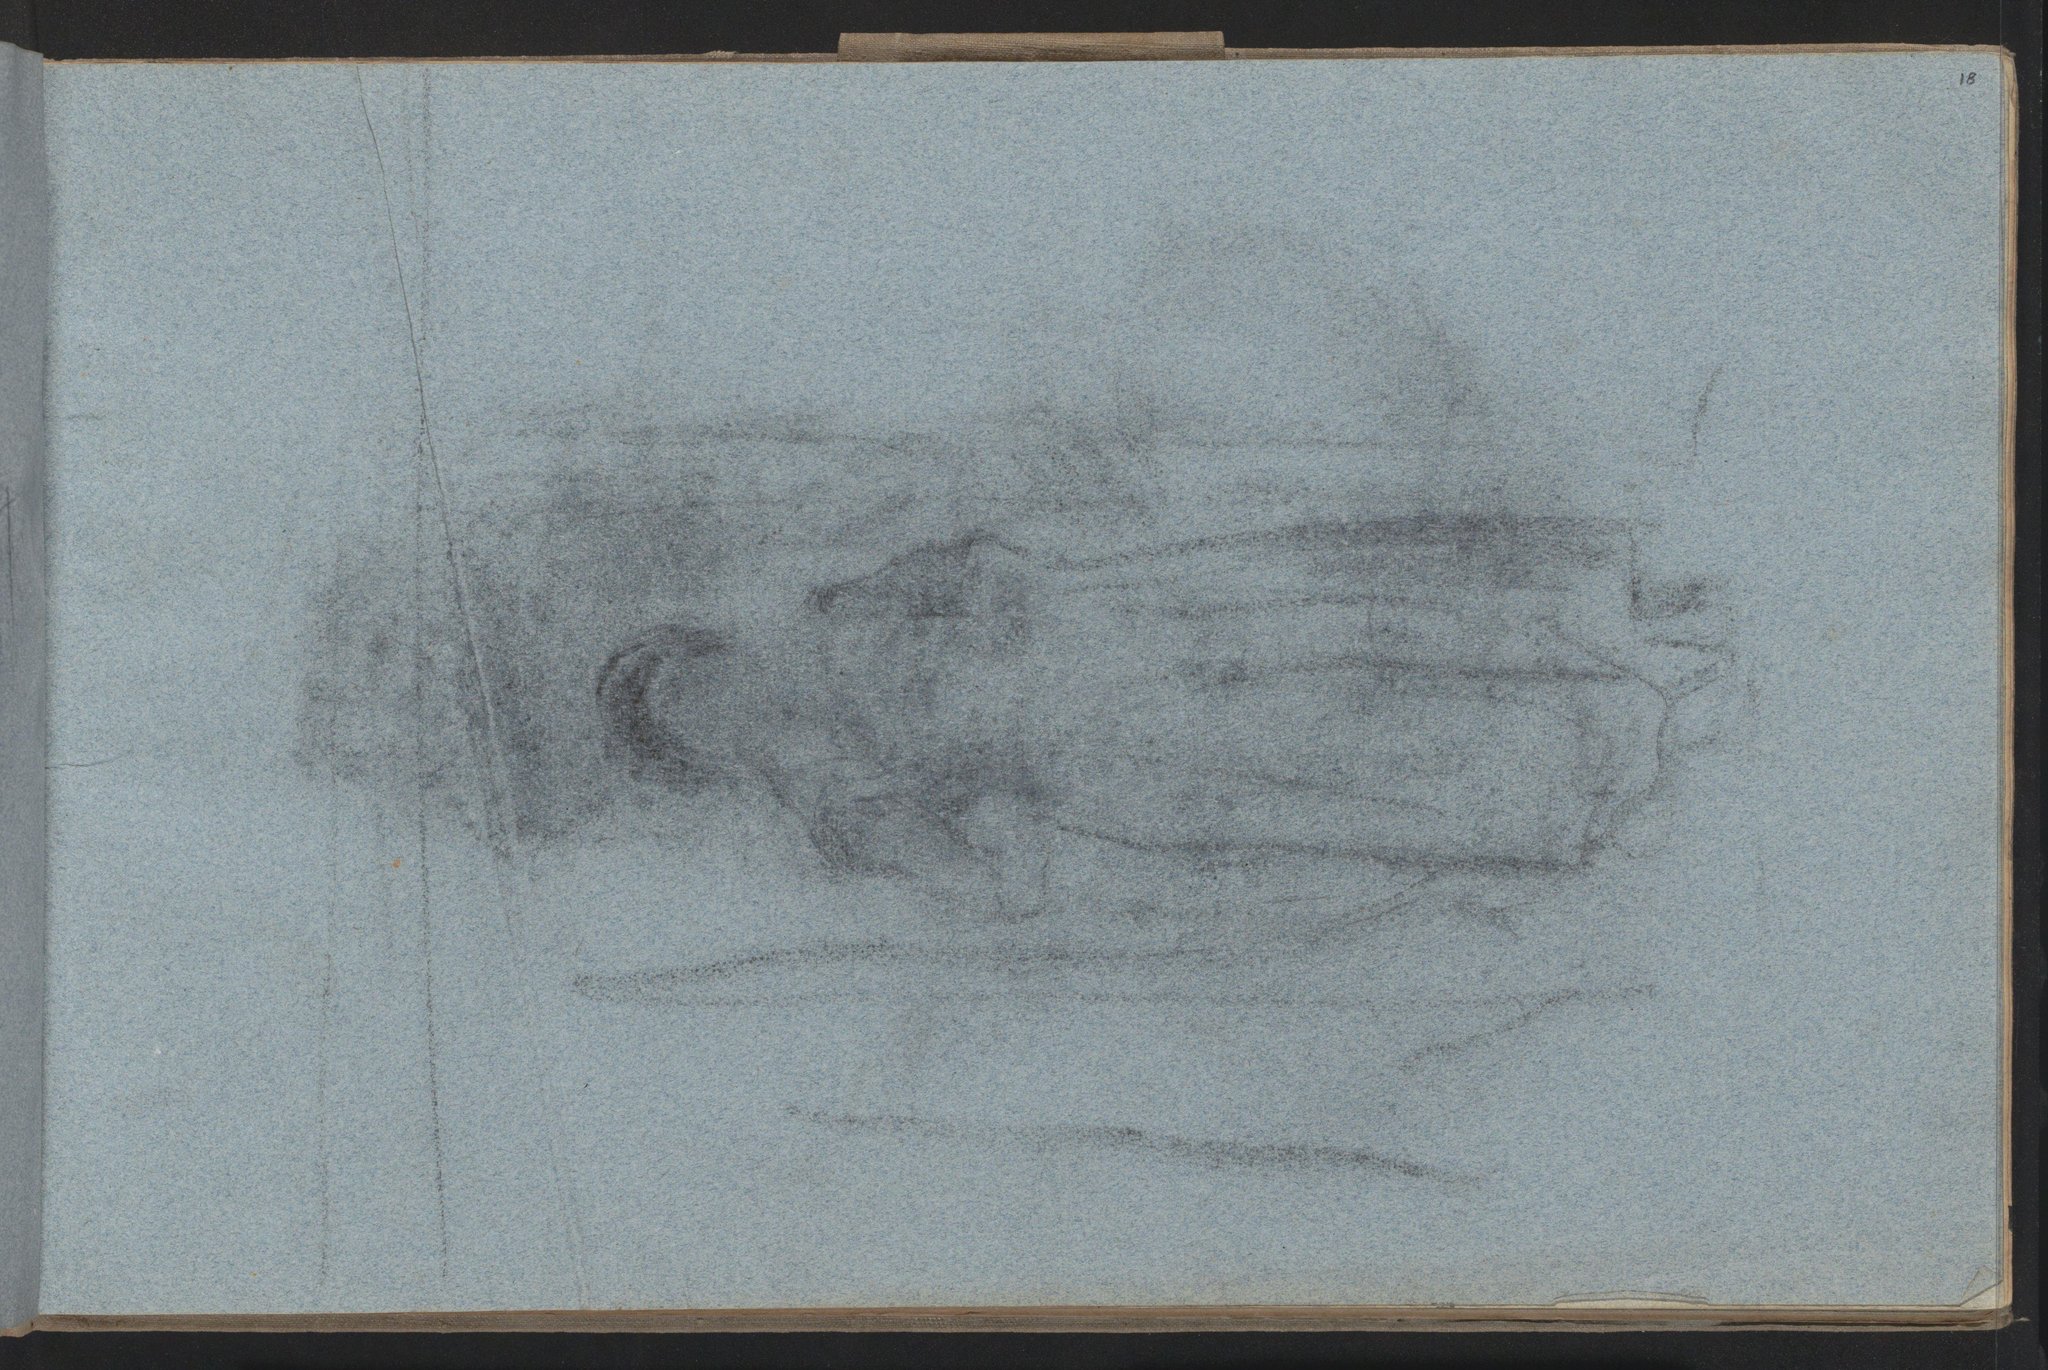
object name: sketchbook leaf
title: Meisje, ten voeten uit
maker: albert neuhuys (1844-1914)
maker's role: draughtsman, painter, print maker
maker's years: 1844-1914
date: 1854-1914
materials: charcoal, paper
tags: girl (child between toddler and youth)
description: Blad 18 recto uit een schetsboek met 51 bladen.